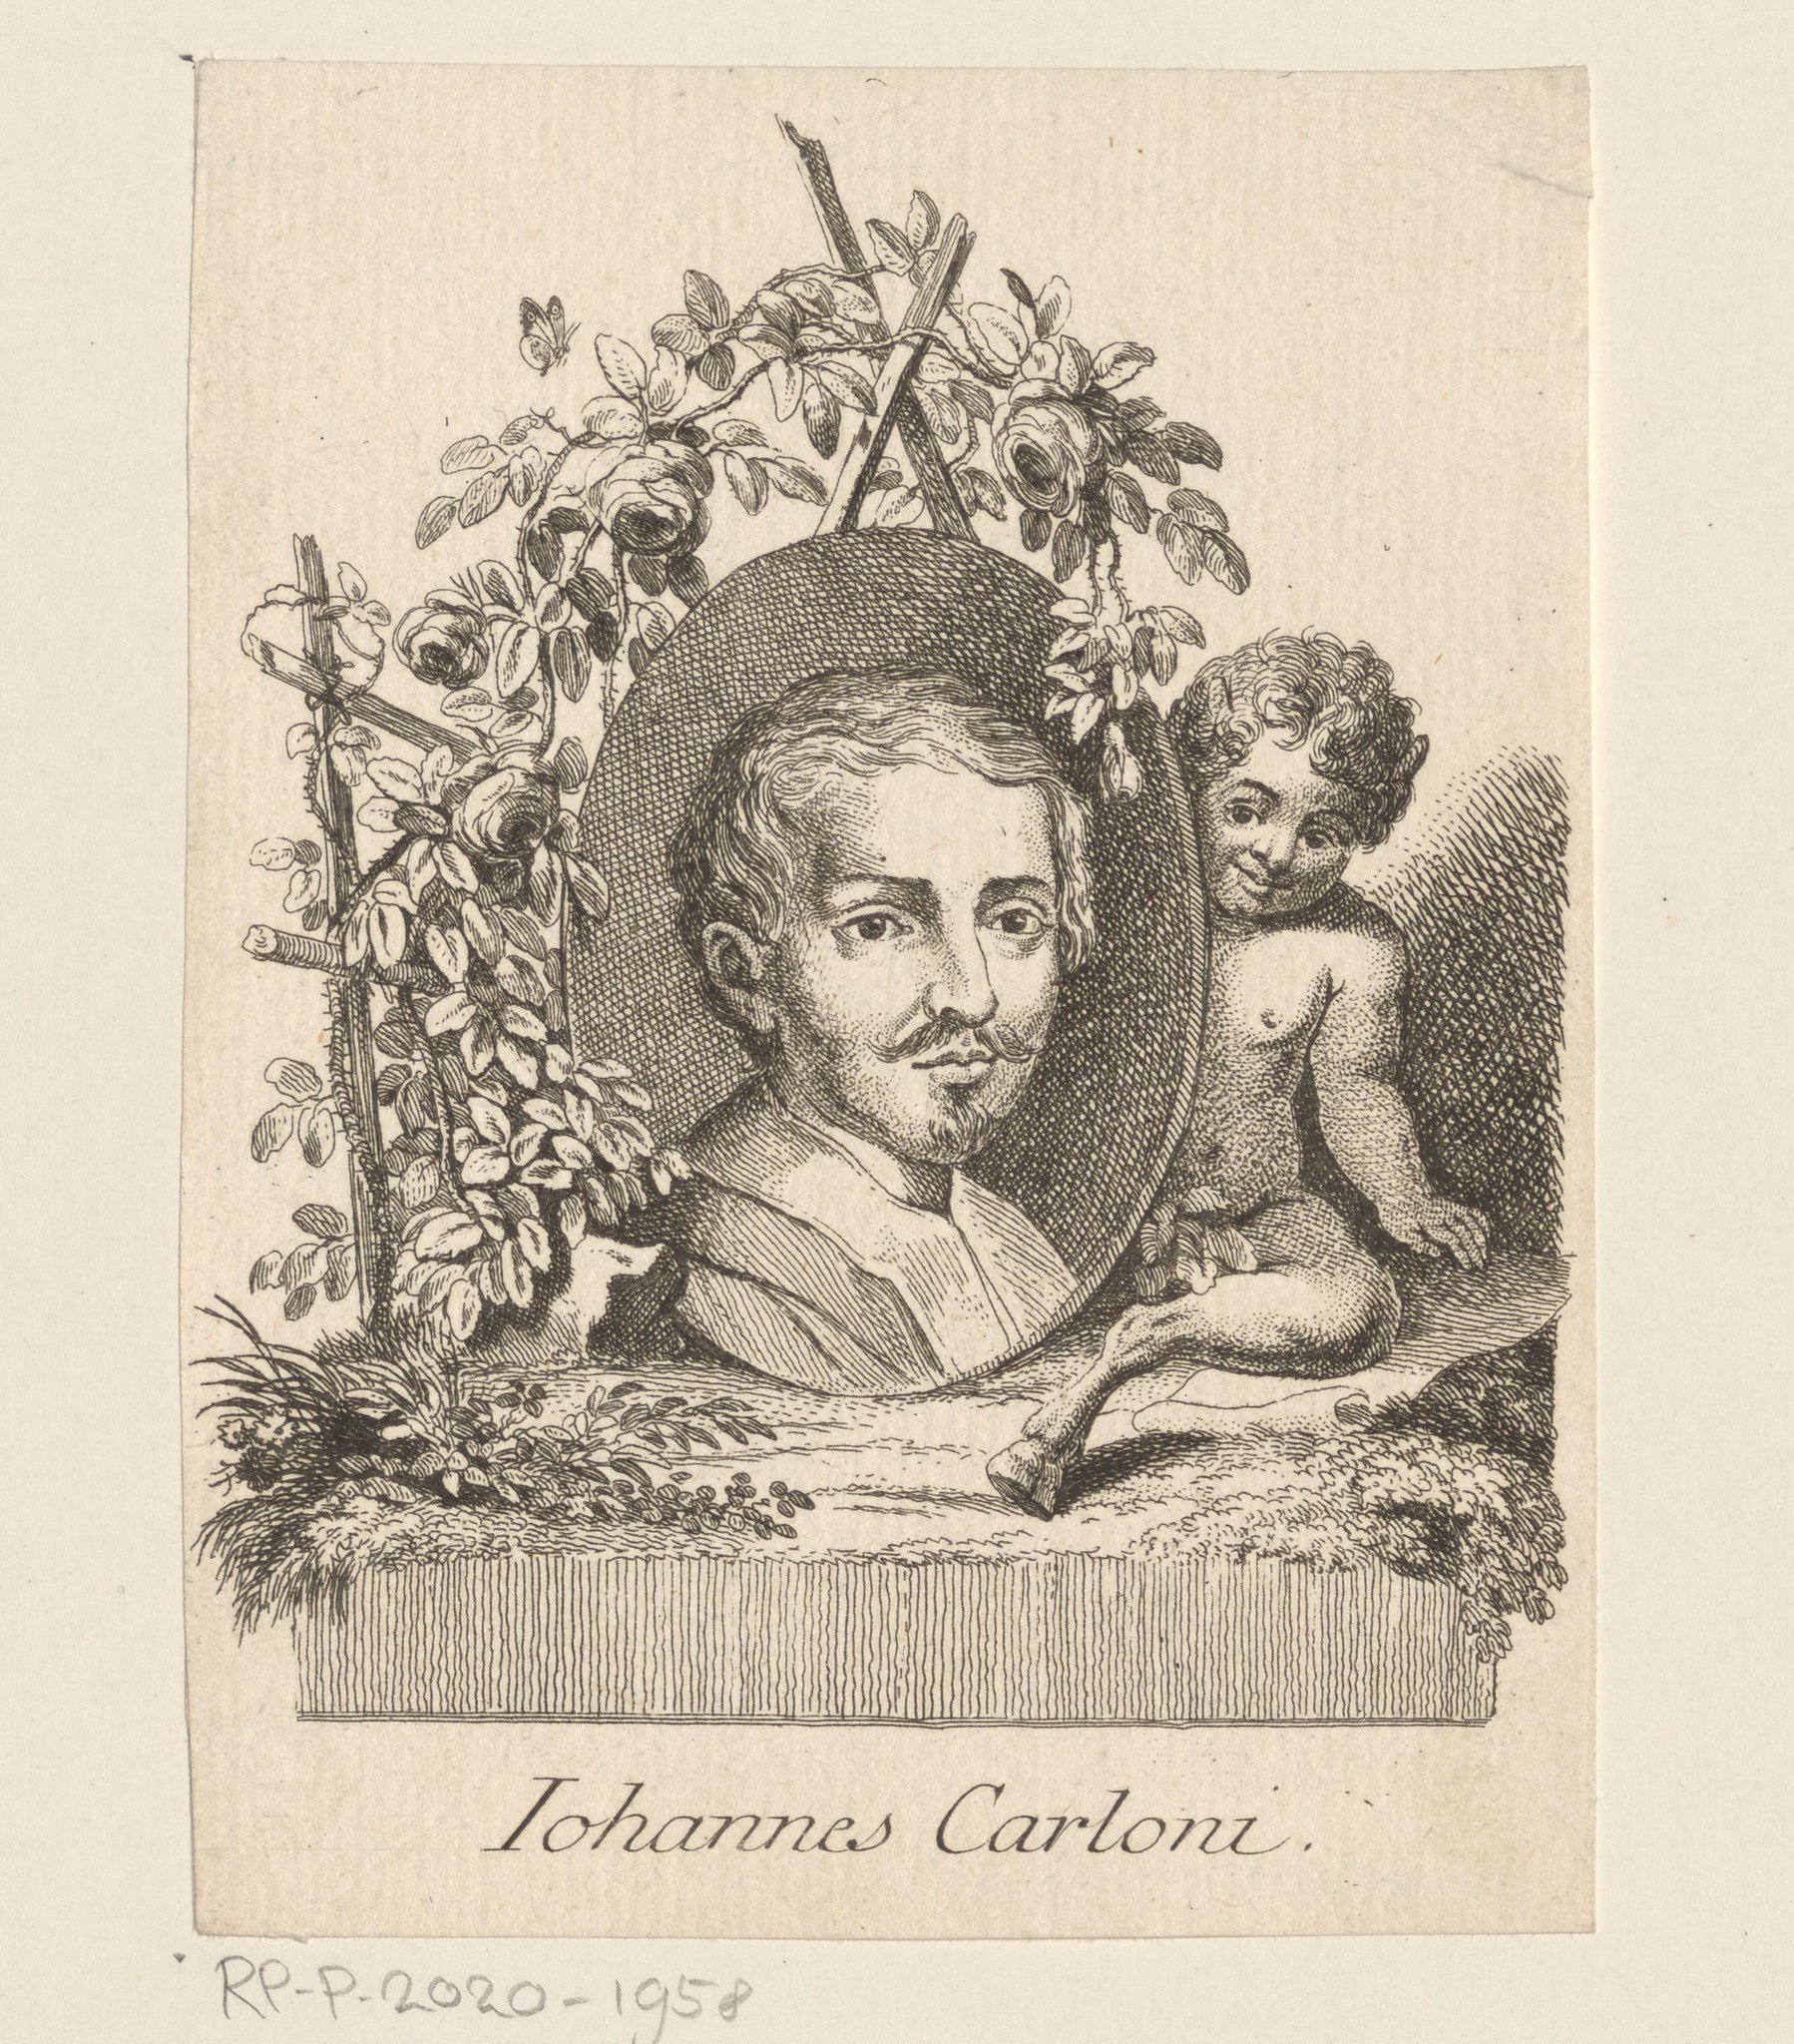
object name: print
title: Portret van Johannes Carloni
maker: Anonymous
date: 1774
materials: paper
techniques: etching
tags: satyrs, fauns, sileni, historical persons, shrubs: rose-bush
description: Prent mogelijk uit: Füssli, Johann Caspar. Geschichte der besten Künstler in der Schweitz. Zürich: Orell, Füssli & Co., 1774, dl. 4.